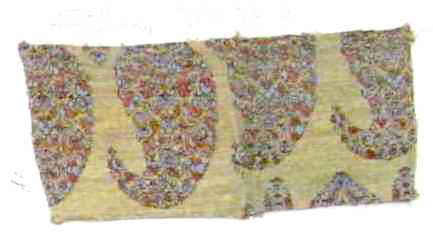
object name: textile fragment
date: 1601-1700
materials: metal thread, silk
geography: iran